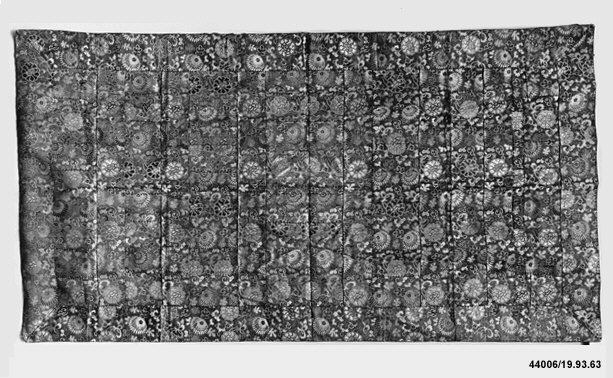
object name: robe, priest's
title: Priest's Robe (Shichijō)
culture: japanese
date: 1673-1681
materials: metal thread, silk